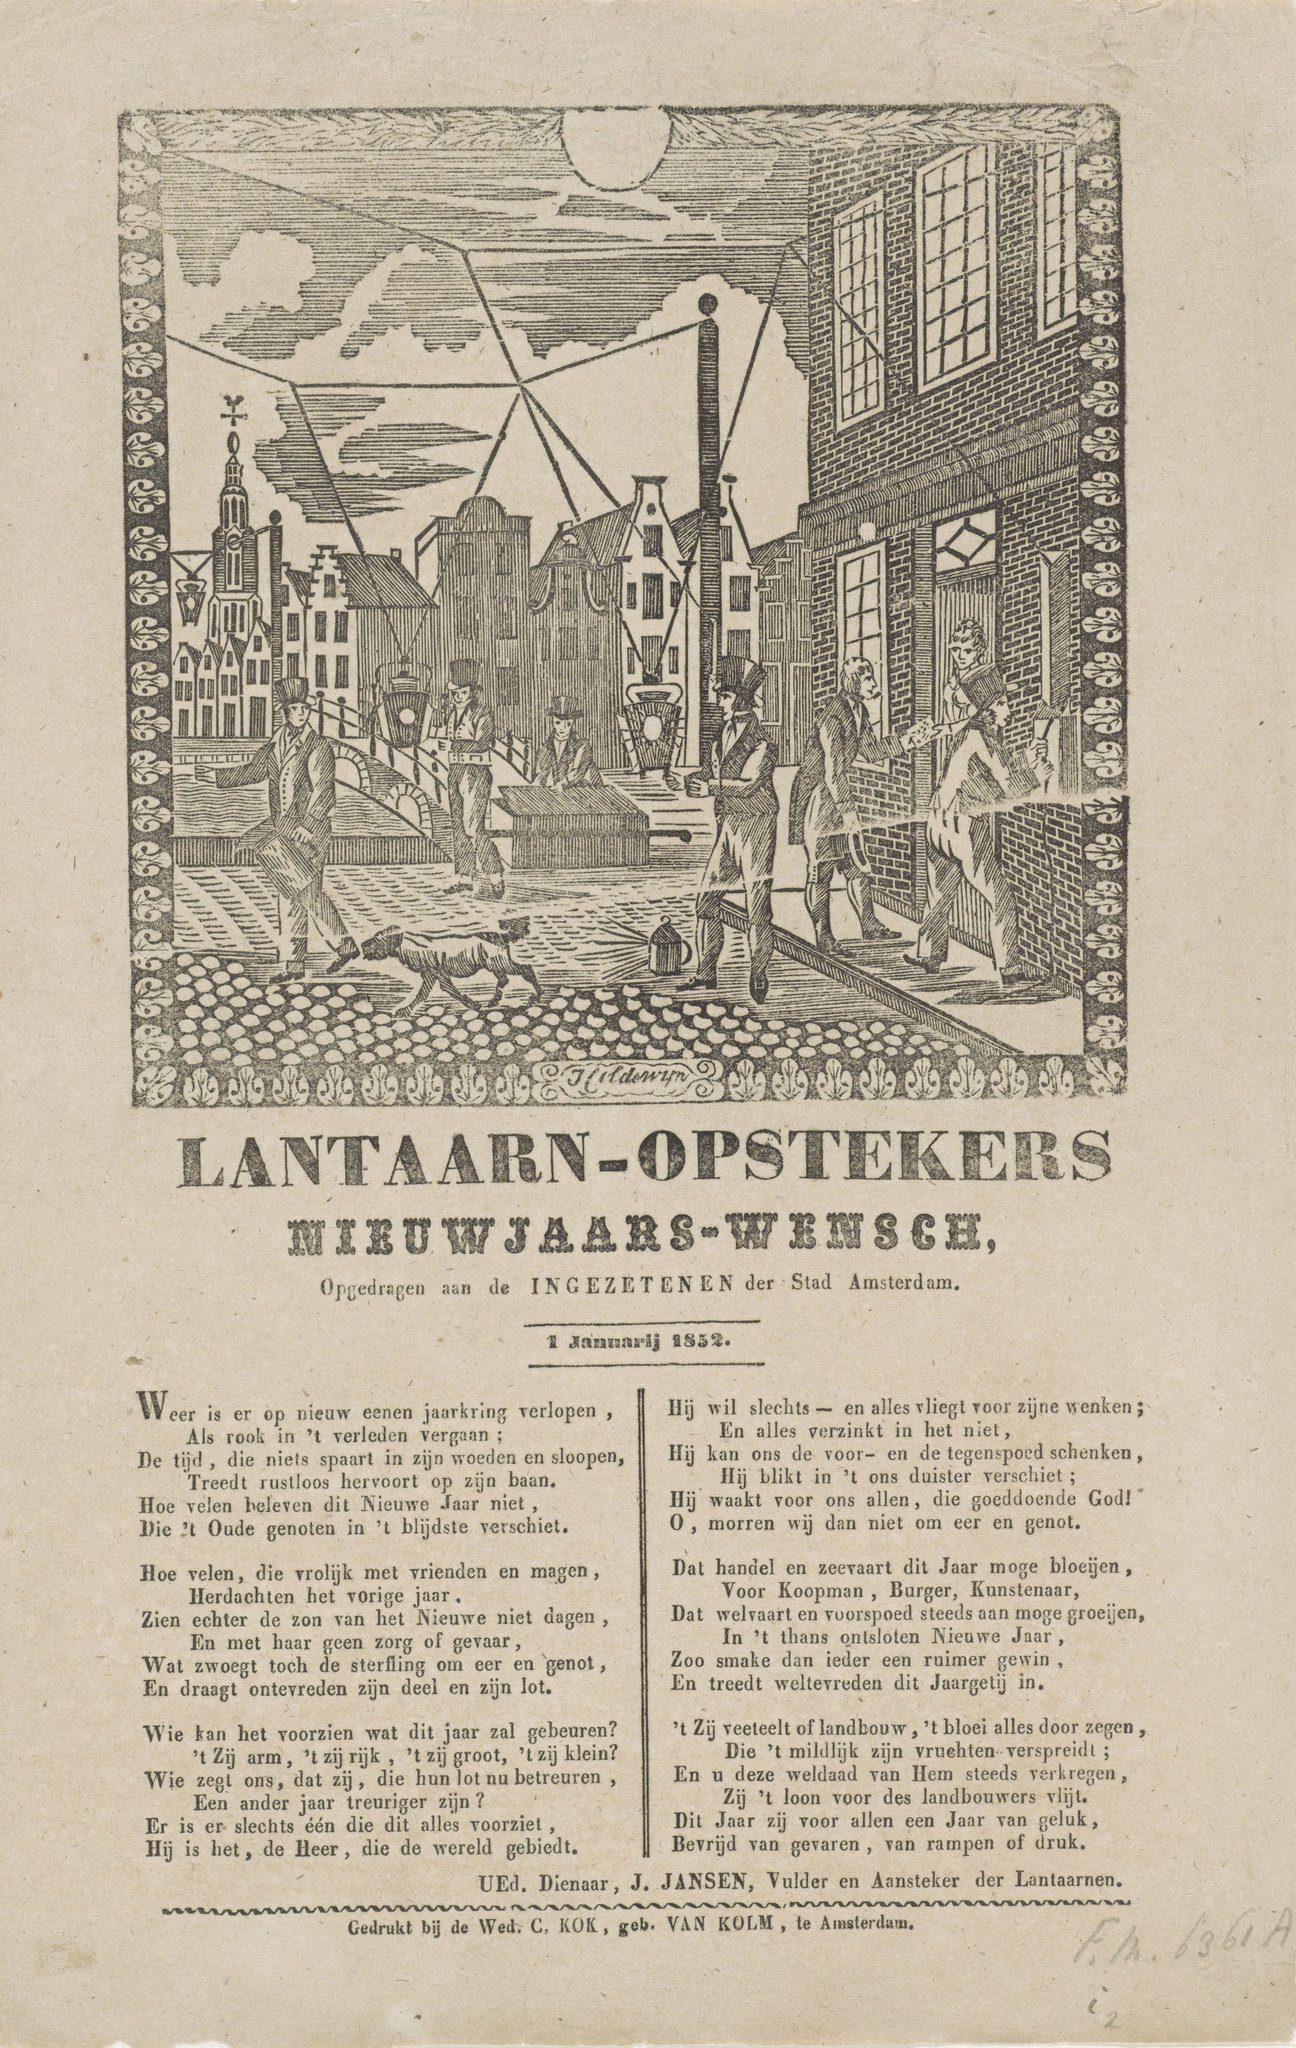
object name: print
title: Lantaarn-opstekers Nieuwjaars-wensch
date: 1851-1852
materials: paper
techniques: letterpress printing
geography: amsterdam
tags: oil-lamp (+ kindling a light; lit, burning light, lamp, candle), street lighting, street, amsterdam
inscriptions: collector's mark: Lugt 2228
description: Nieuwjaarswens van de Amsterdamse lantaarnopstekers en vullers voor het jaar 1852. Gezicht in een straat in Amsterdam waar enkele mannen bezig zijn de straatlantaarns te vullen en aan te steken. Een andere man haalt geld op bij een huis. Met gedicht in twee kolommen. Van de lantaarnopsteker: J. Jansen.